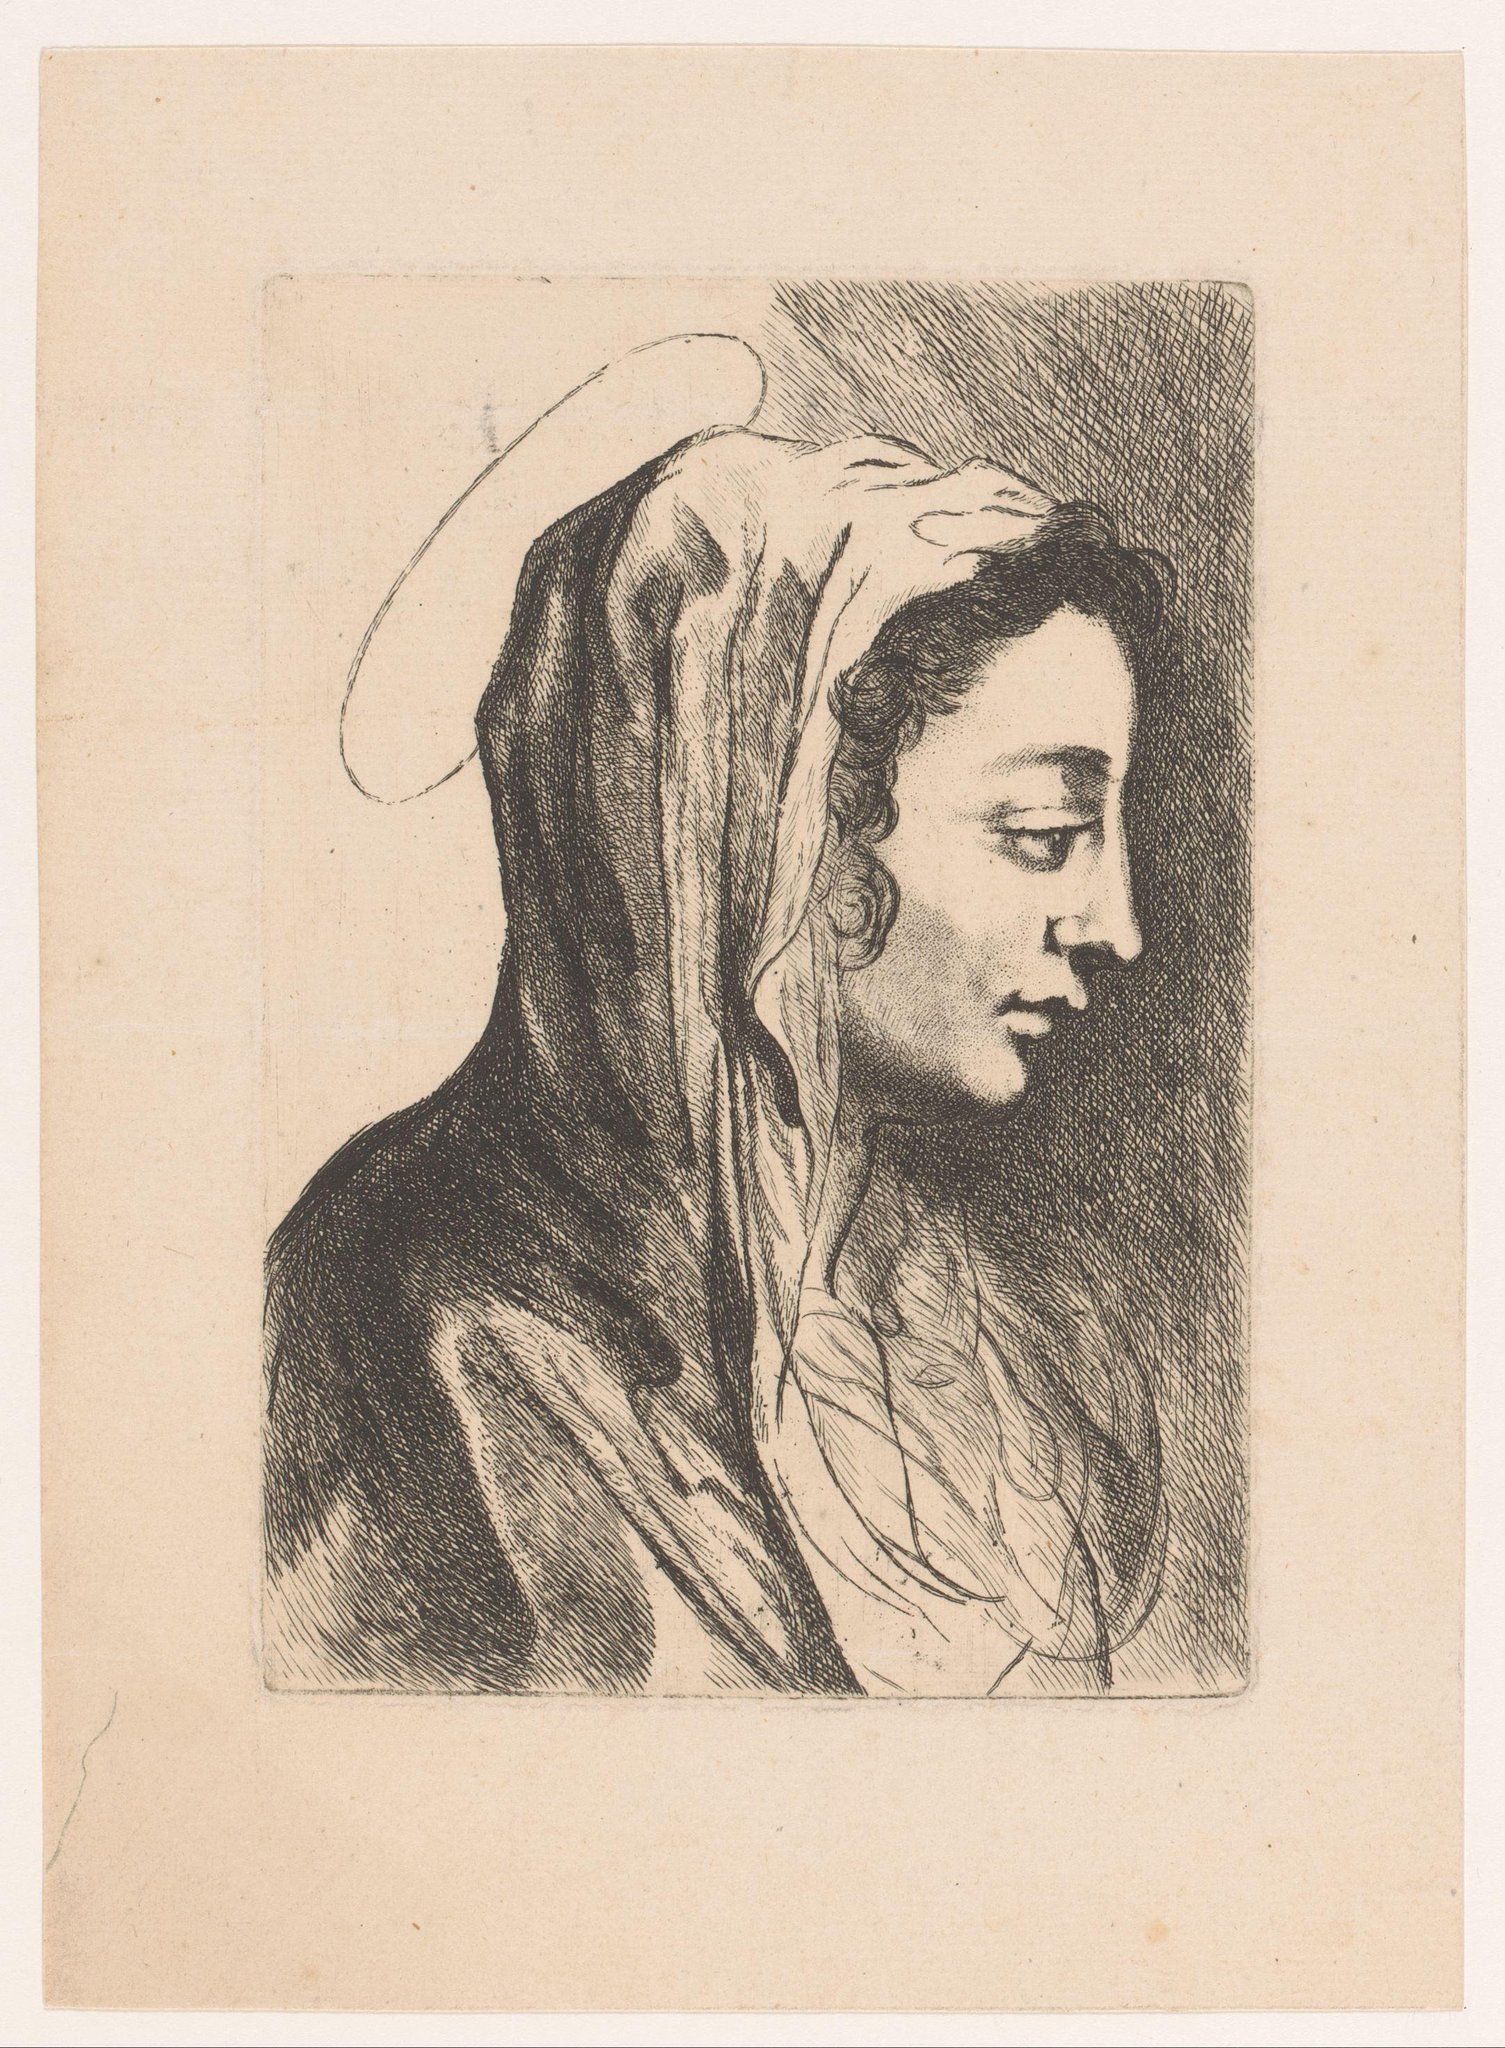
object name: print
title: Buste van Maria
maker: Anonymous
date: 1700-1850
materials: paper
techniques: engraving, etching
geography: france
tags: 'portraits' of mary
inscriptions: collector's mark: Lugt 240